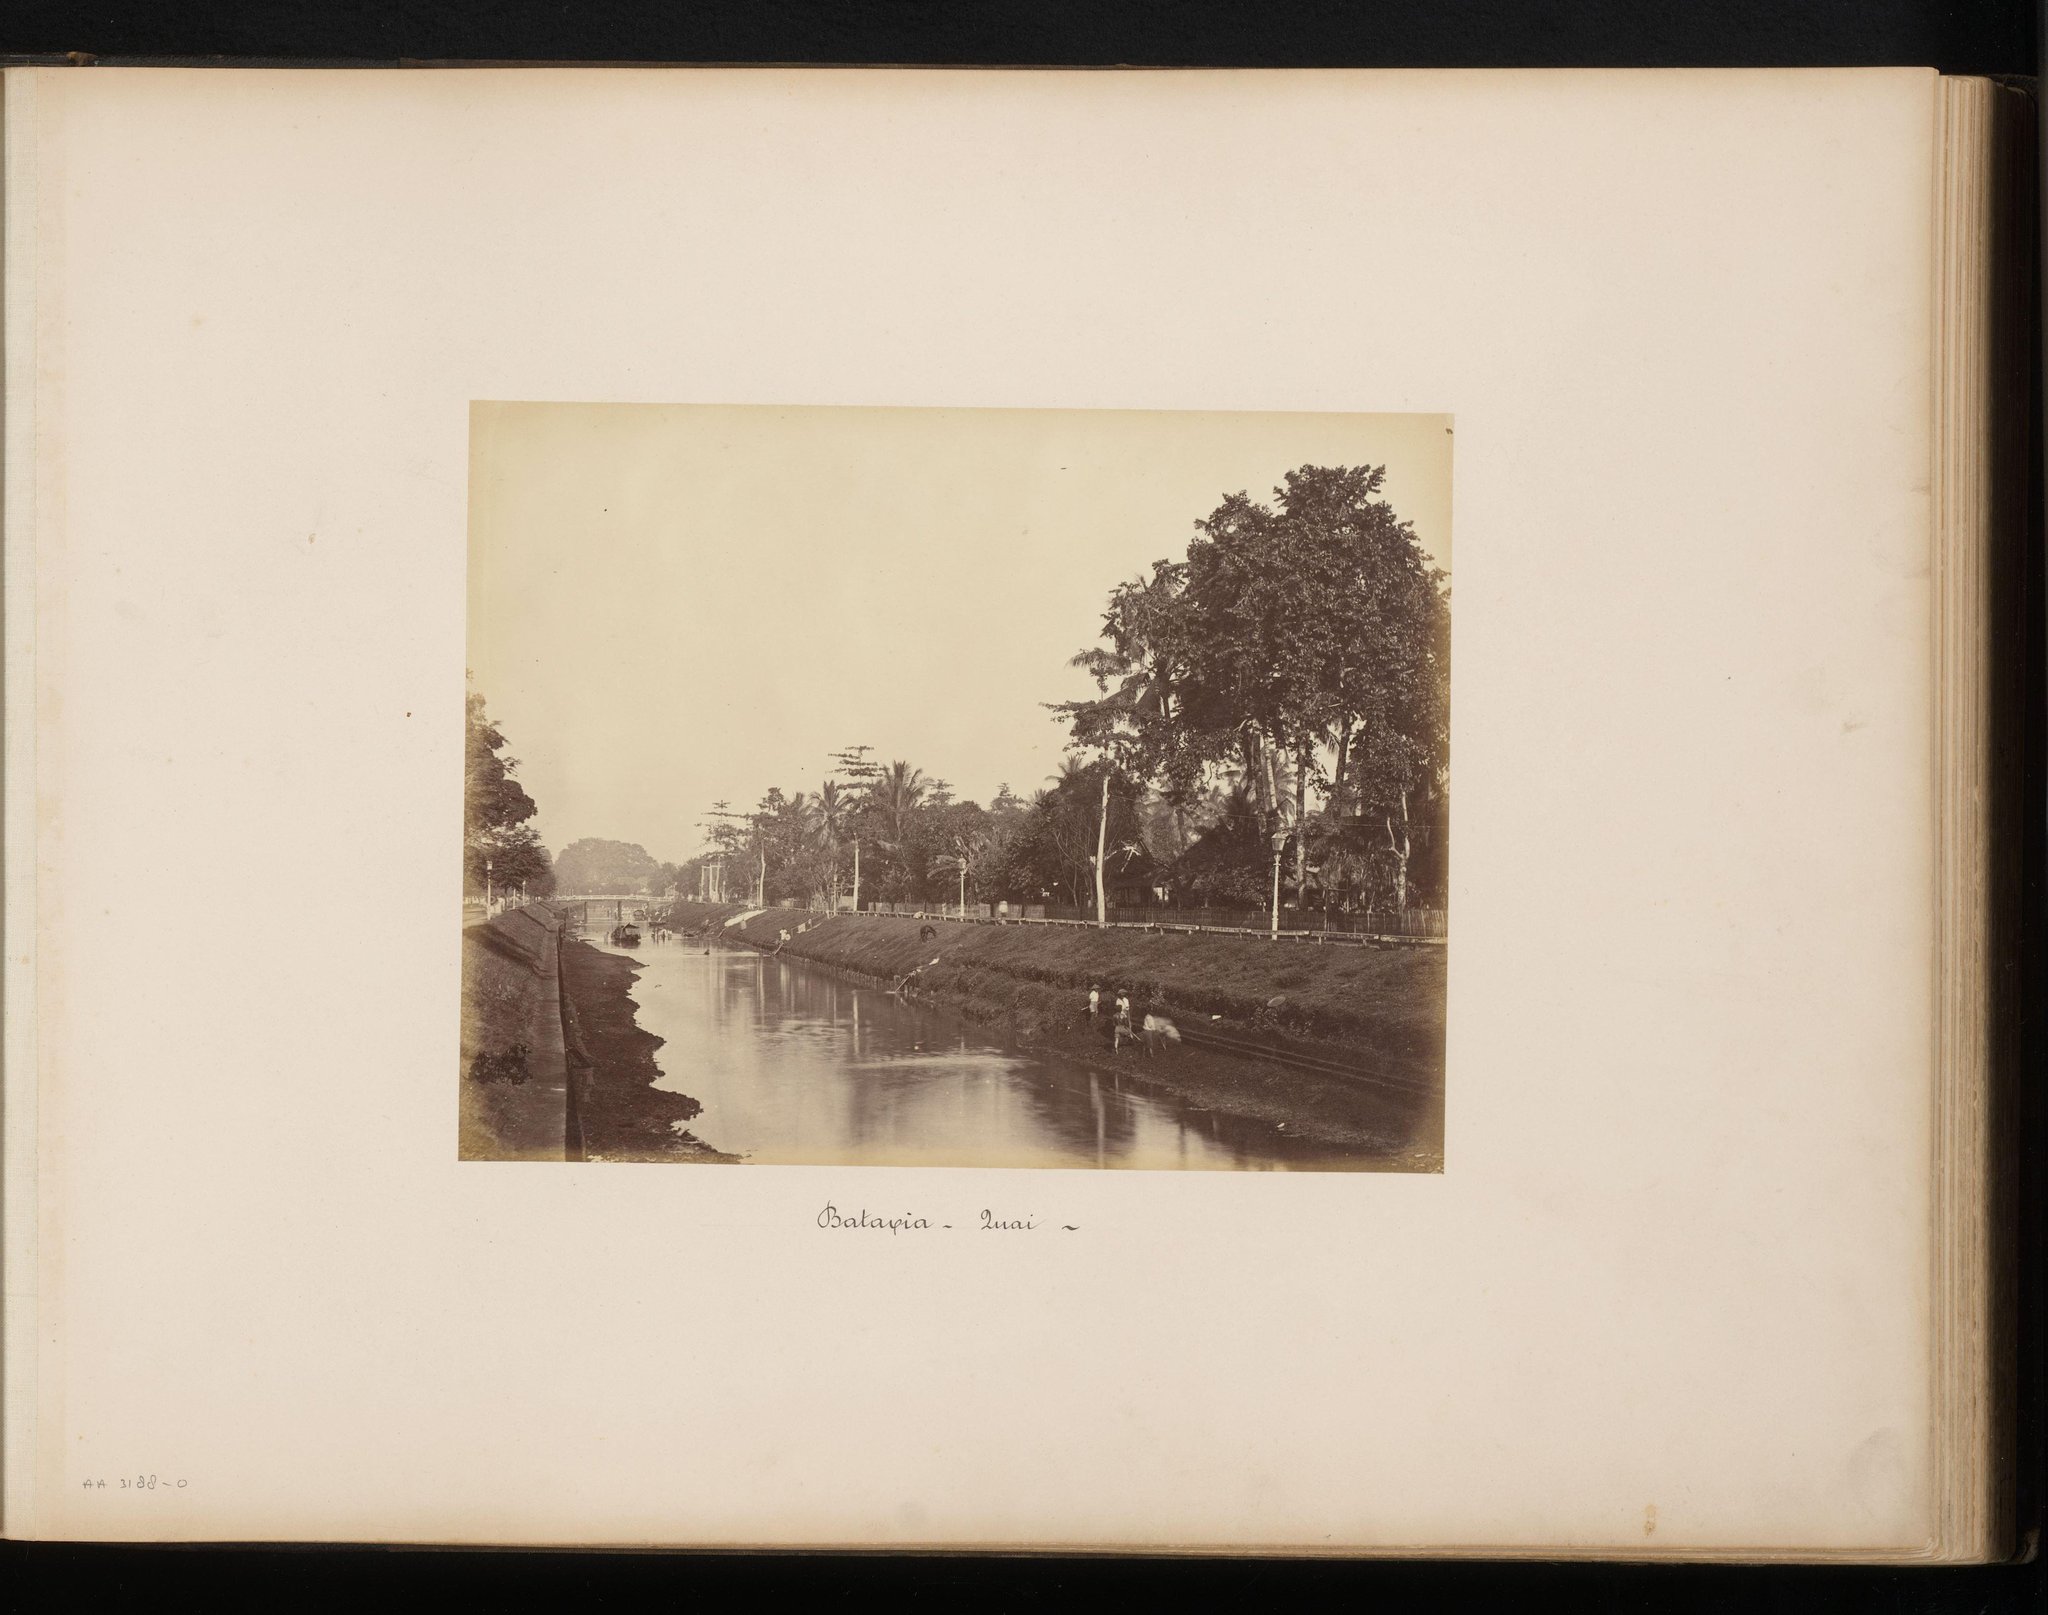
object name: photograph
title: Kanaal en kade in Batavia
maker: Anonymous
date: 1880-1883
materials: photographic support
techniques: albumen print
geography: batavia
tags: canal, batavia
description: Onderdeel van Reisalbum met opnames van bezienswaardigheden in Egypte, Nederlands-Indië, Singapore en Ceylon.